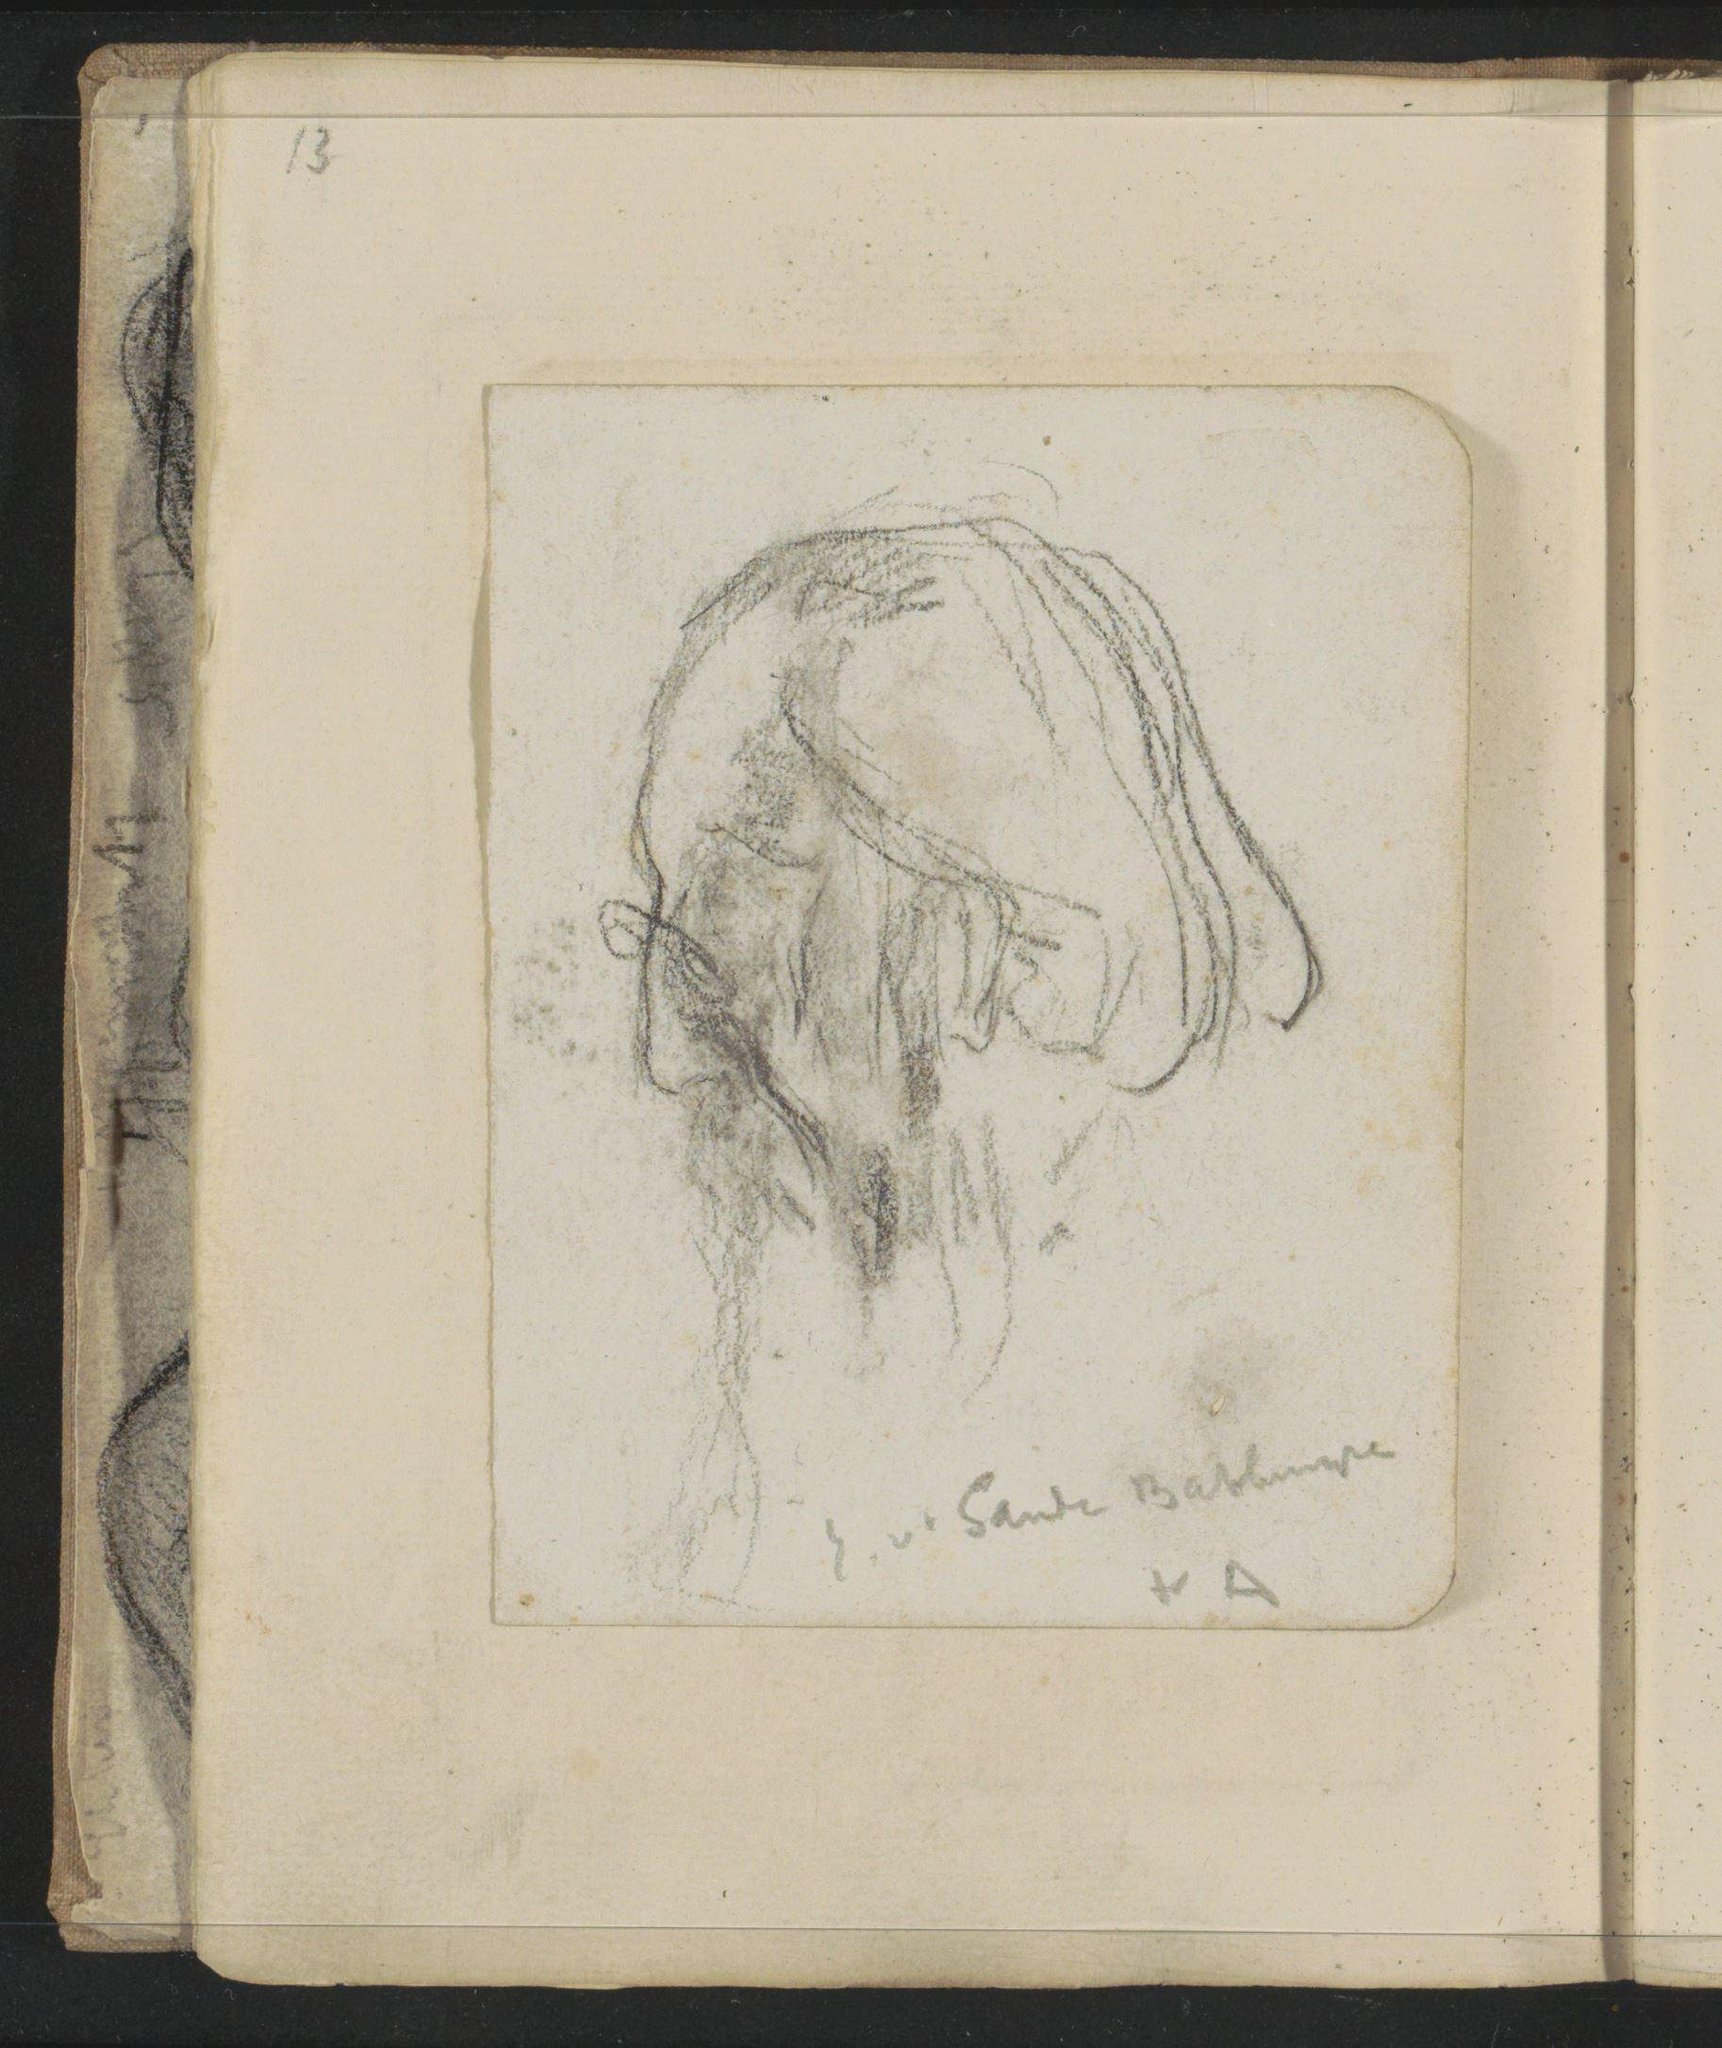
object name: sketchbook leaf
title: Portret van kunstenaar Julius Jacobus van de Sande Bakhuyzen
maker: floris arntzenius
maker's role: draughtsman, print maker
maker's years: 1864-1925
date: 1883-1914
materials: chalk, paper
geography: the hague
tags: the hague, painter, print maker, julius jacobus van de sande bakhuyzen, portrait, self-portrait of artist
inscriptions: signature: ‘Fl A.’, name: ‘J. vd Sande Bakhuyzen’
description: Blad, geplakt op pagina 13 uit een schetsboek met 82 pagina's.